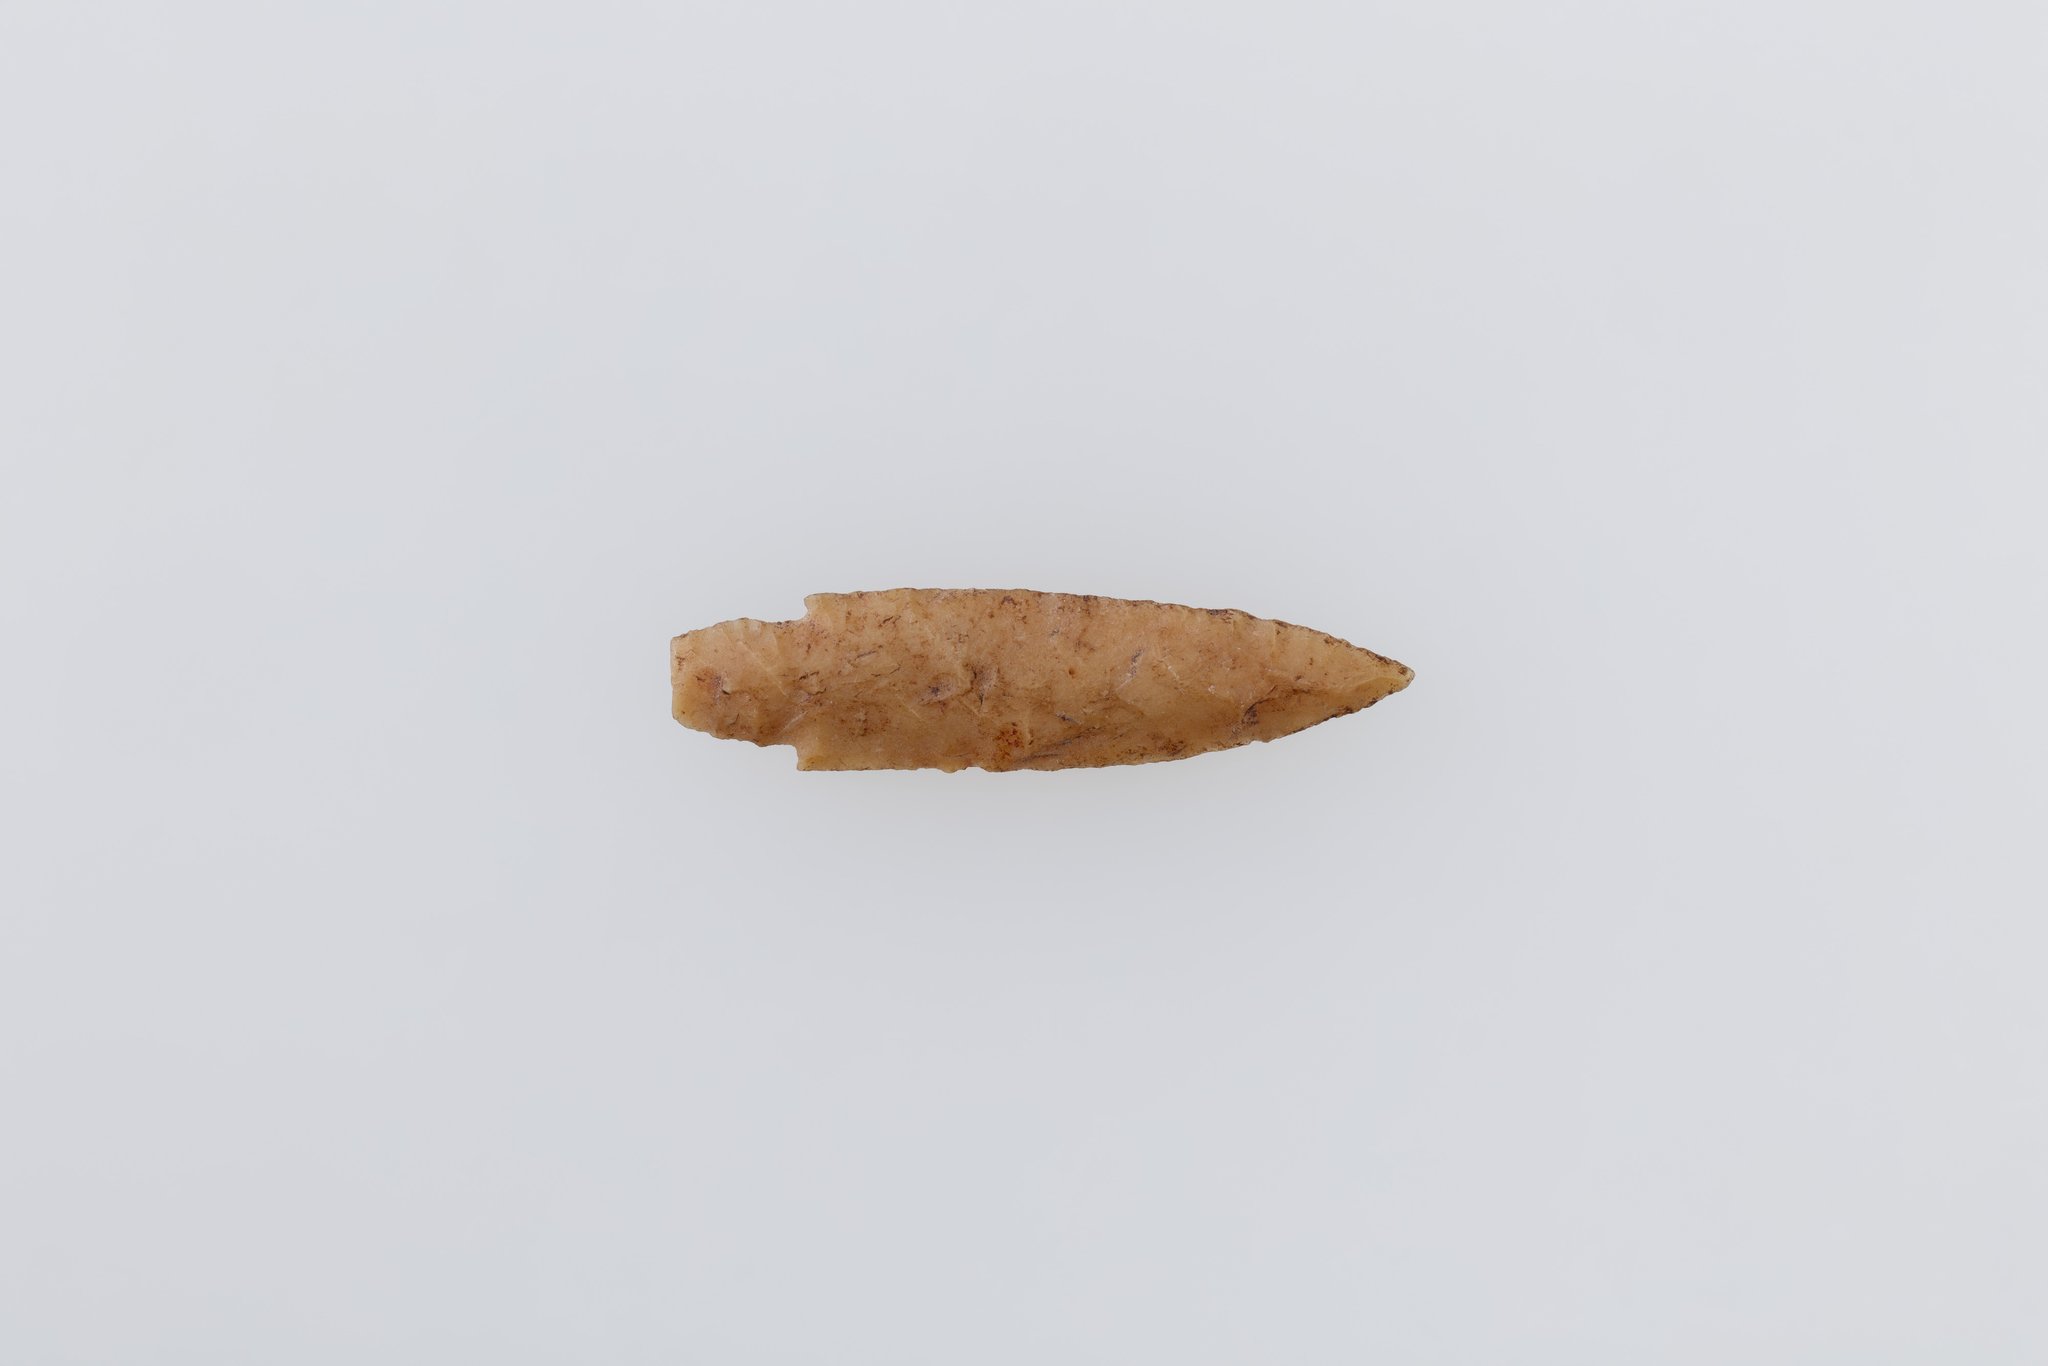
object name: arrowhead, projectile point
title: Projectile Point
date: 3100-2649 BCE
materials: stone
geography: egypt